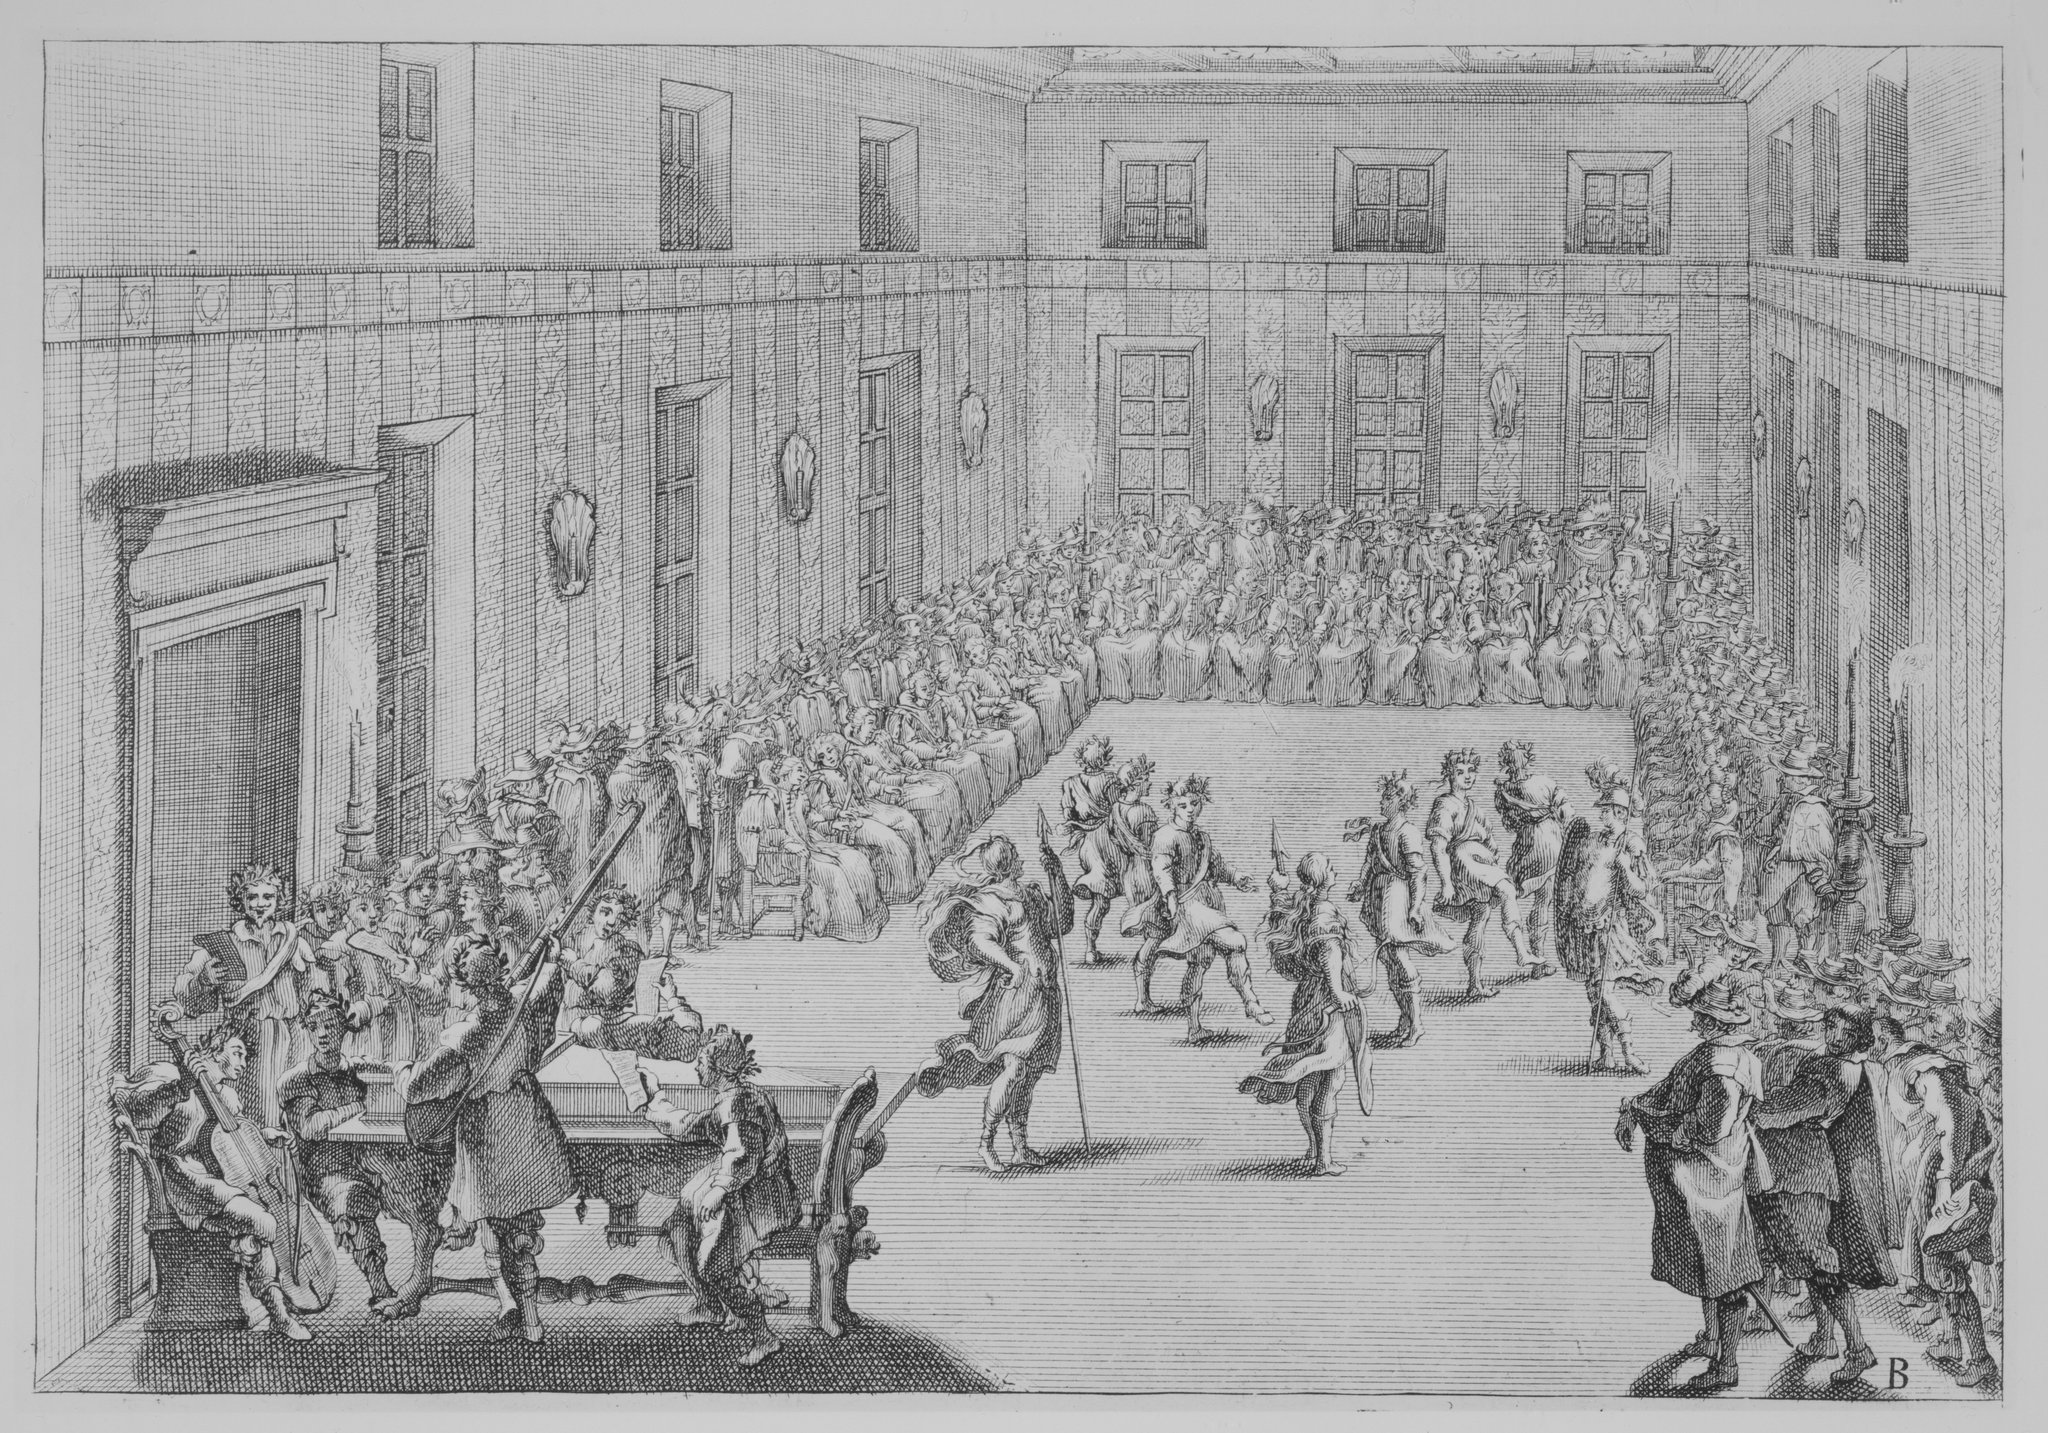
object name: book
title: Libro De Catafalchi, Tabernacoli, con varij designi di Porte fenestre et altri ornamenti di Architettura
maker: lodovico scalzi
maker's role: designer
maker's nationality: italian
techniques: etching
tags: human figures,doors,interiors